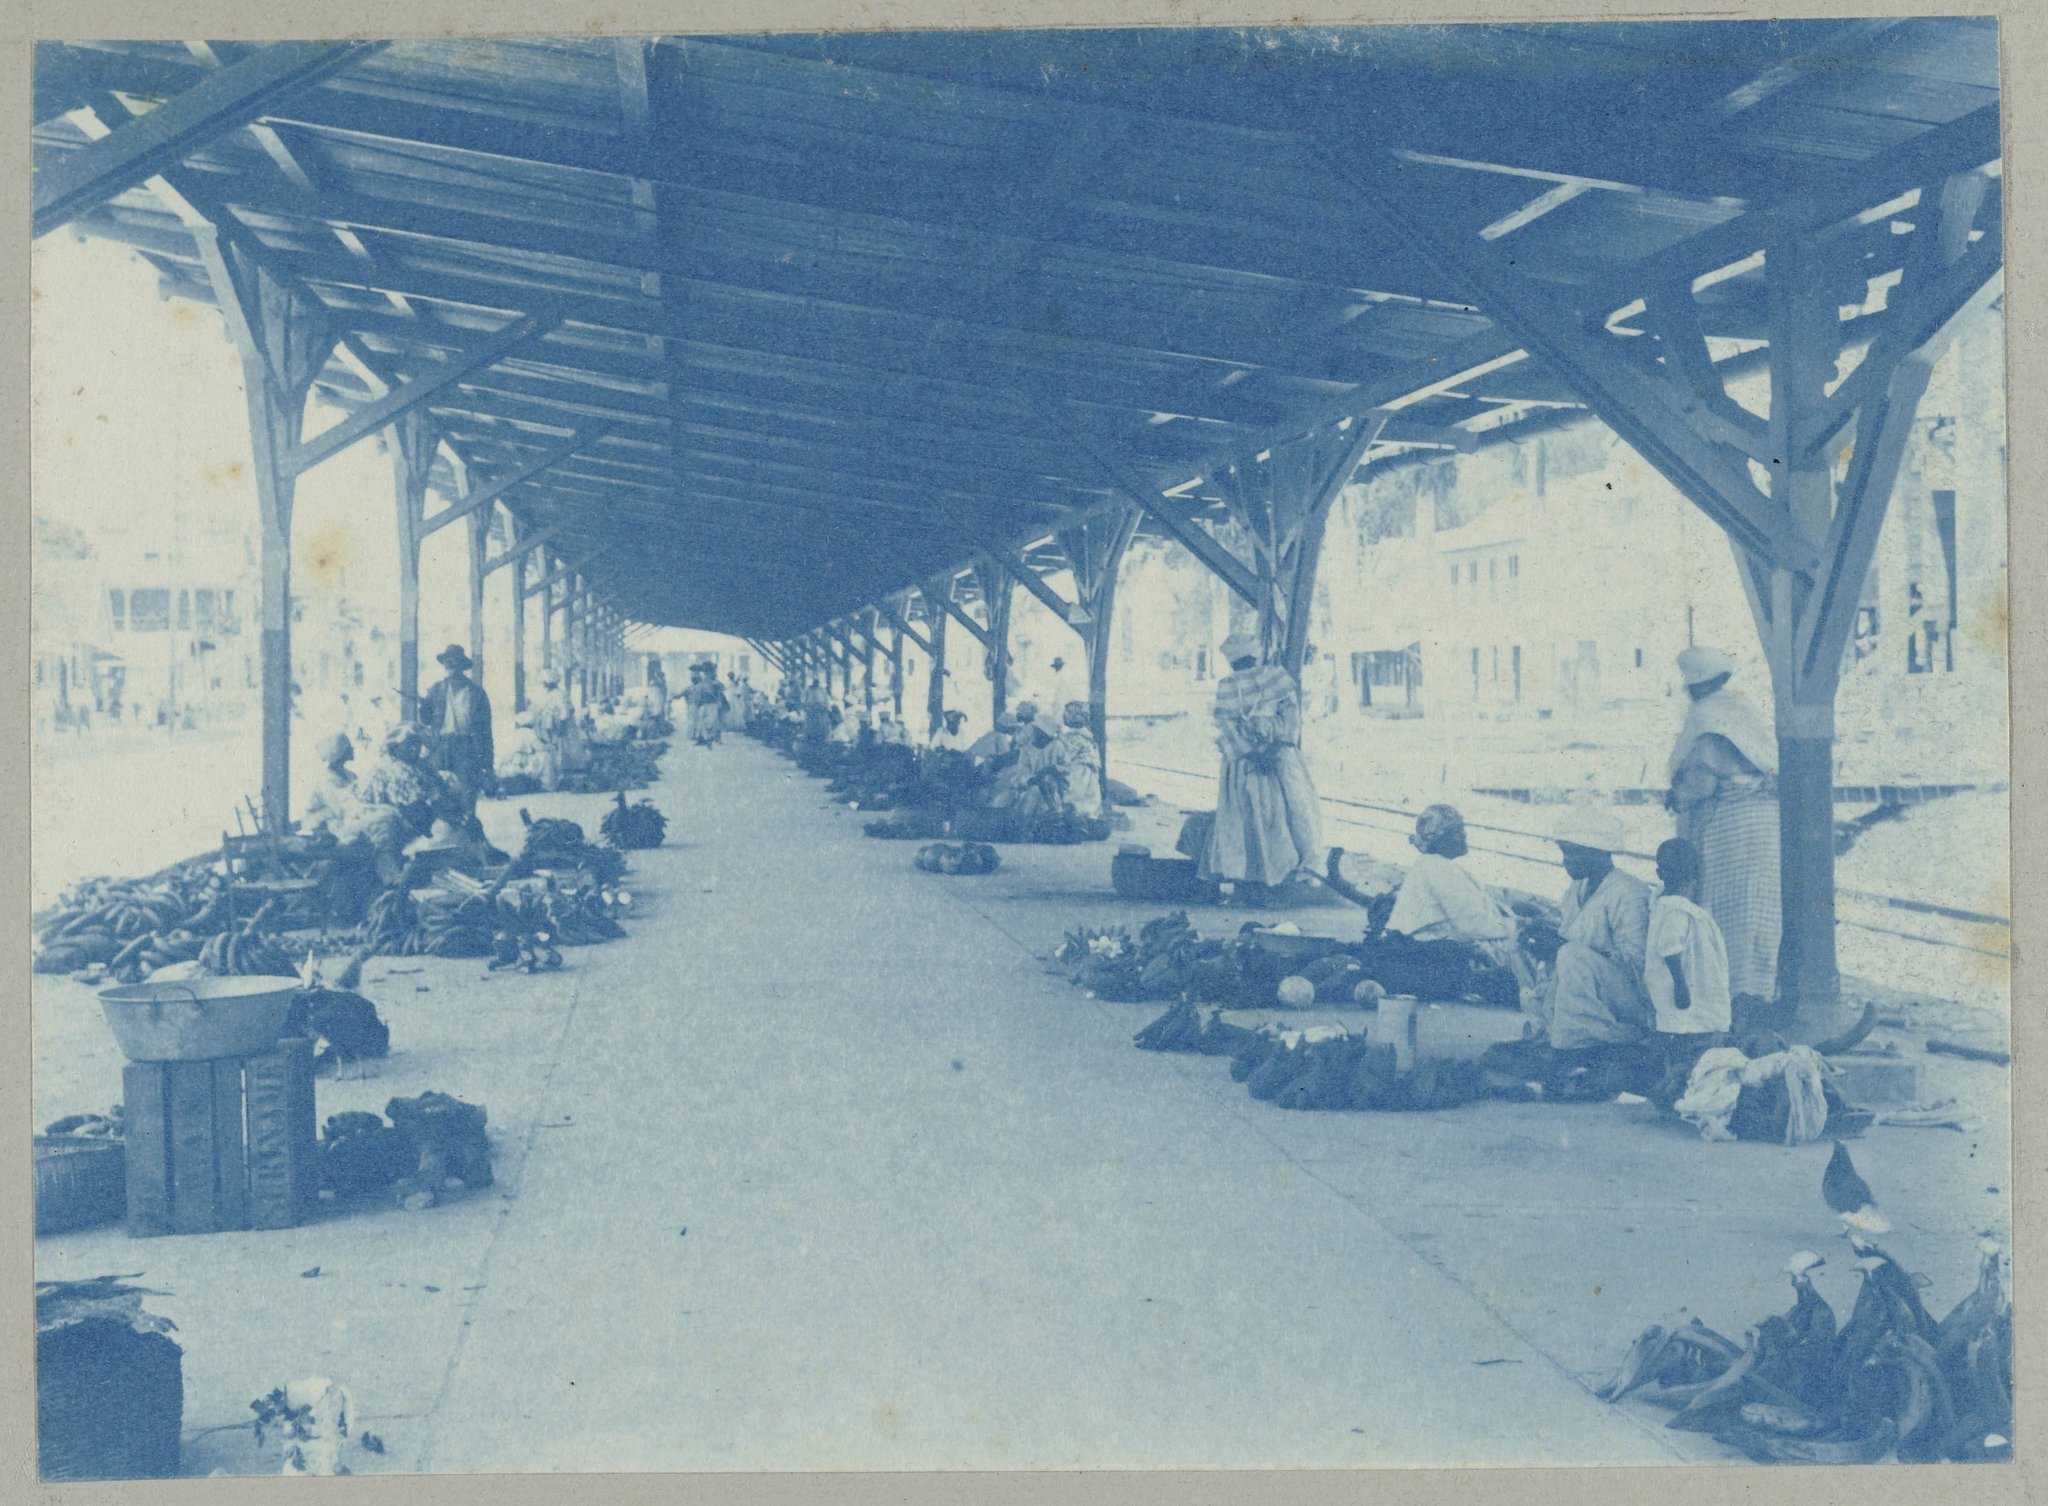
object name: photograph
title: Overdekte markt aan Heiligenweg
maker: hendrik doijer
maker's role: engineer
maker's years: 1863-1925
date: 1903-1910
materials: photographic support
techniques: cyanotype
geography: suriname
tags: suriname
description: Gezicht in de overdekte markt aan de Heiligenweg te Paramaribo. Verkopers zitten met hun waar op de grond. Onderdeel van het fotoalbum Souvenir de Voyage (deel 2), over het leven van de familie Doijer in en rond de plantage Ma Retraite in Suriname in de jaren 1903-1910.